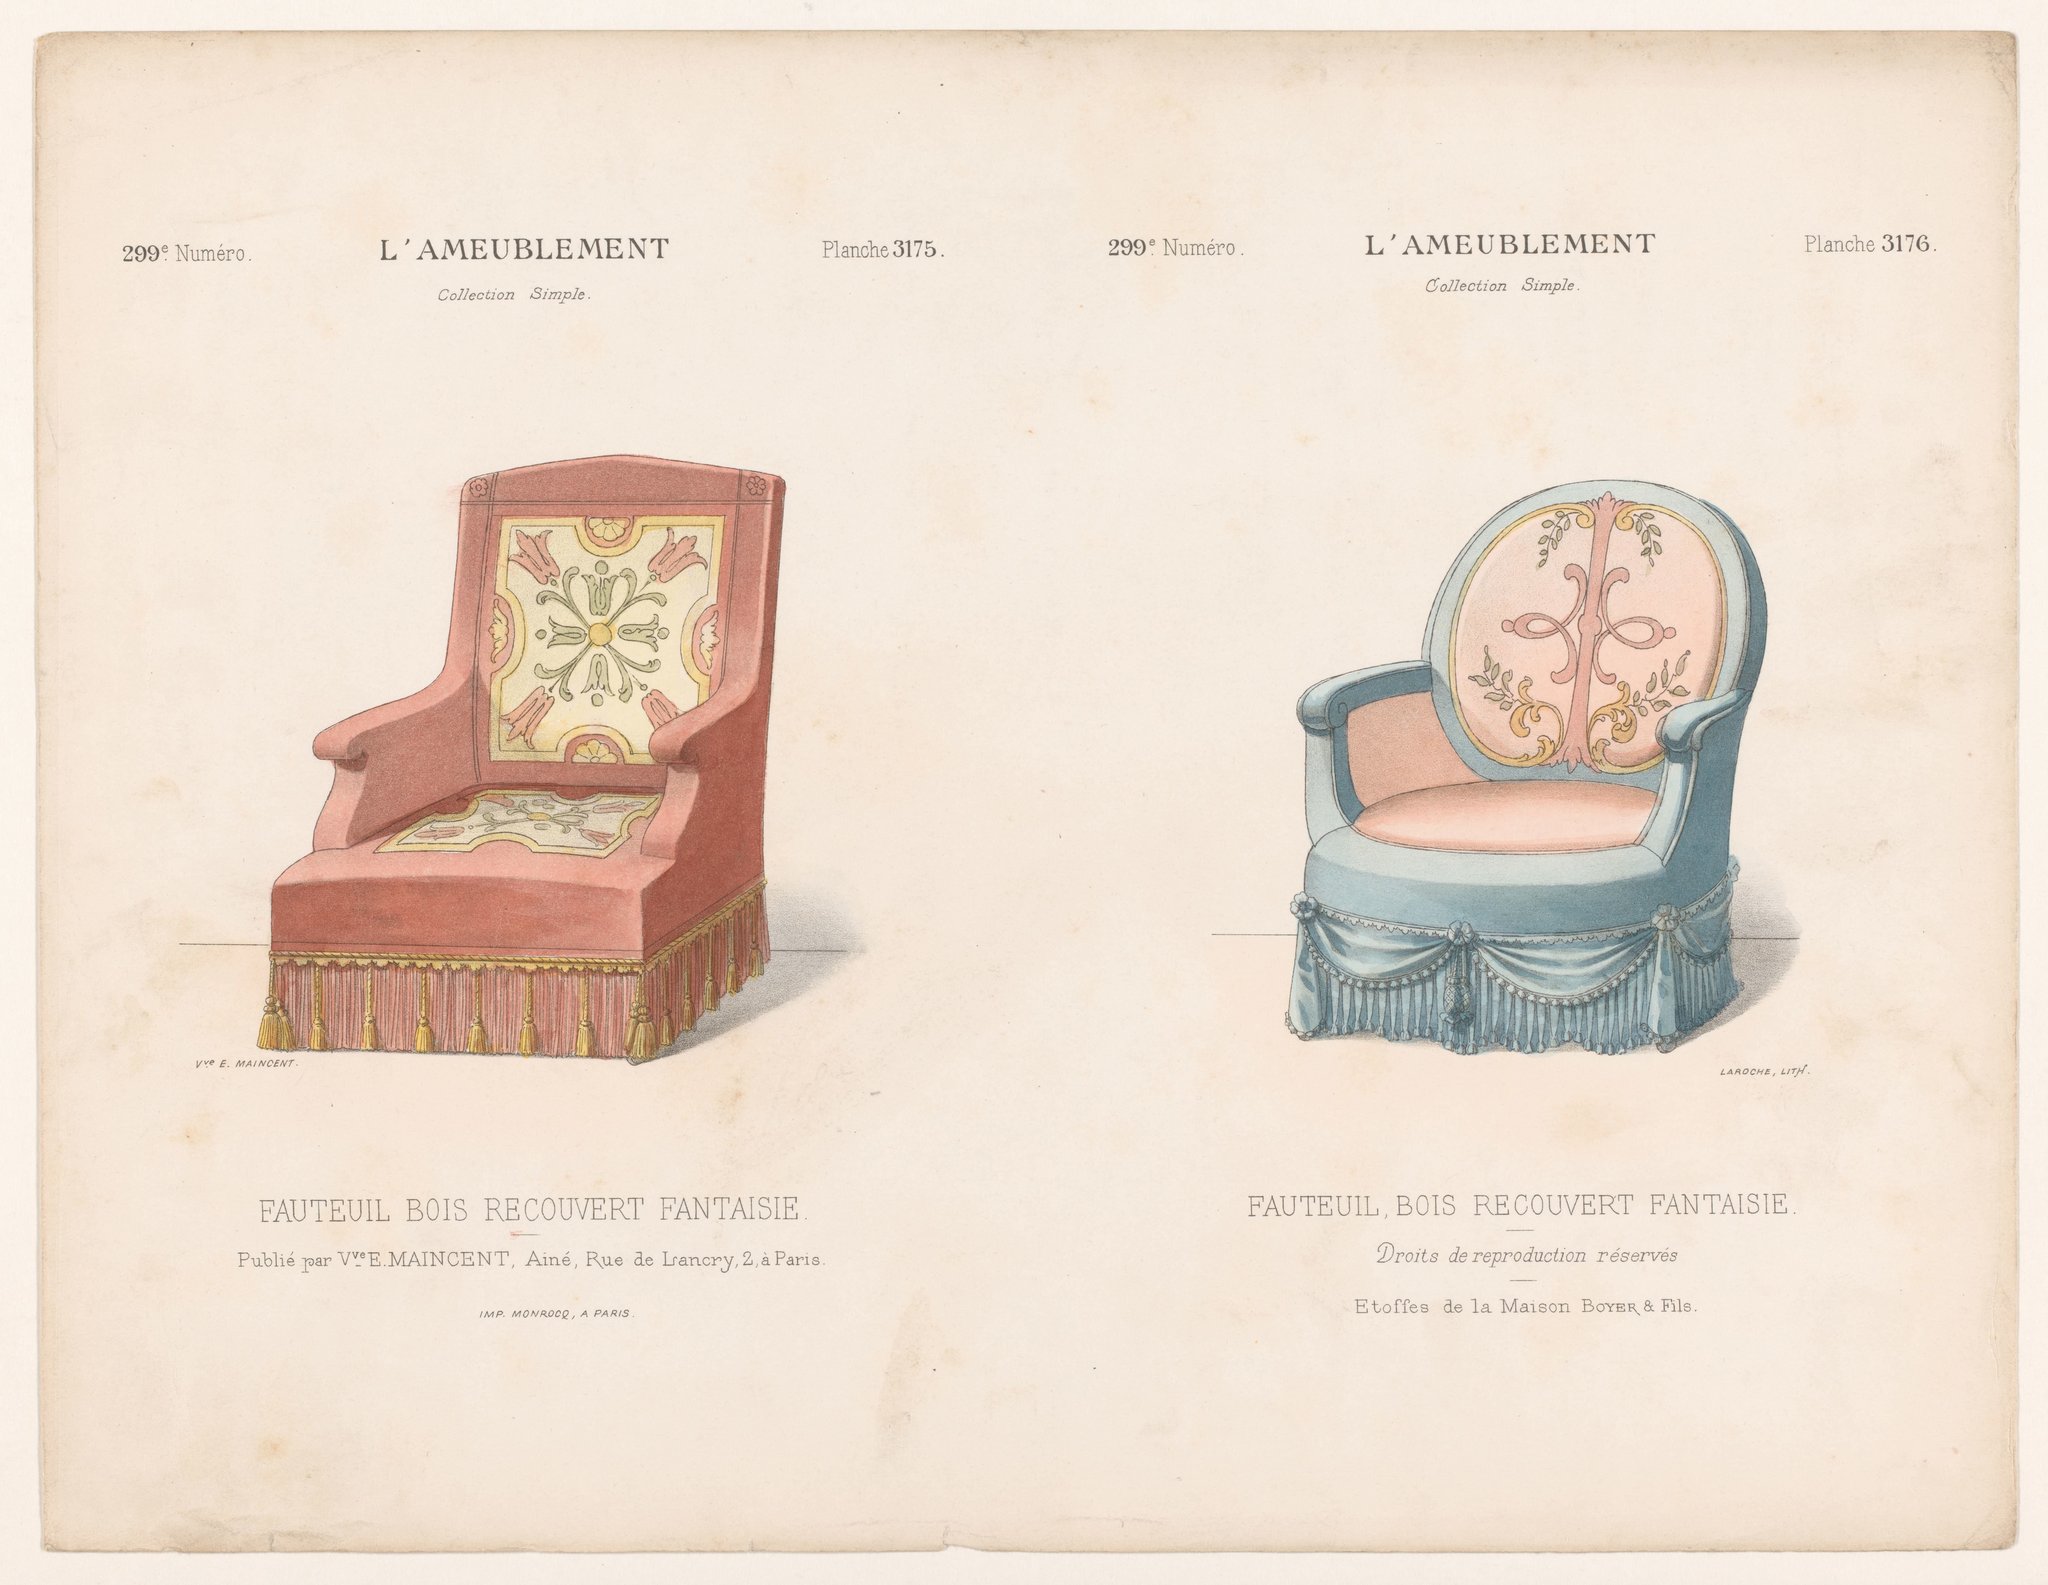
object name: print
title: Fauteuil bois recouvert fantaisie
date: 1895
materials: paper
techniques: hand coloring, lithograph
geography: paris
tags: seating furniture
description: Twee fauteuils. Prent uit 299e nummer (livraison).